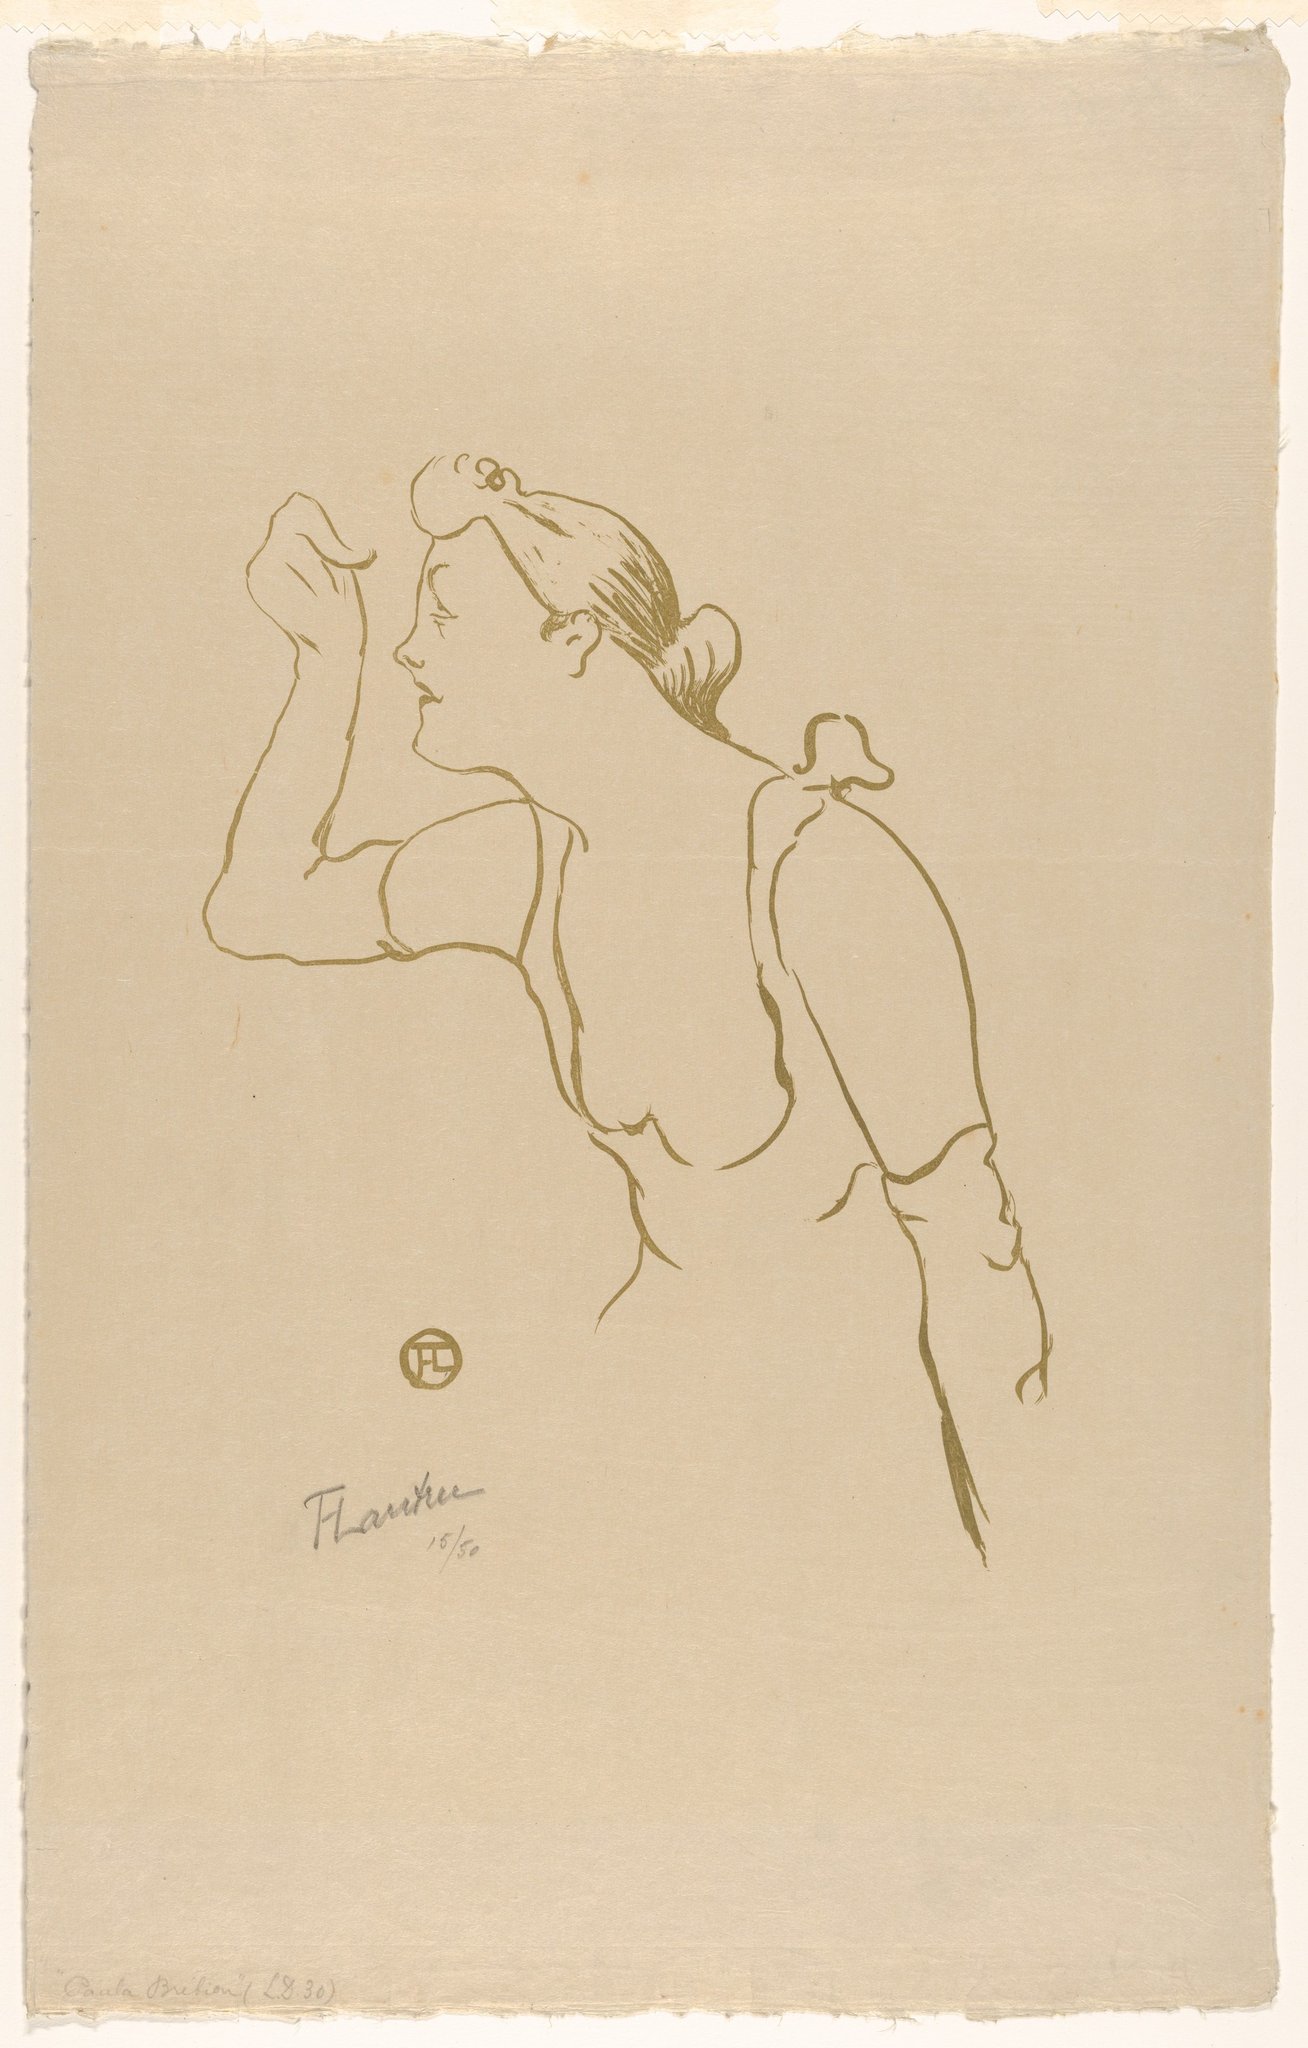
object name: print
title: Paula Brébion (from Le Café Concert)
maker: henri de toulouse-lautrec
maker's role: artist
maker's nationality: french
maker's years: 1864-1901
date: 1893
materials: paper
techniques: brush, lithograph, printing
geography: france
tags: women